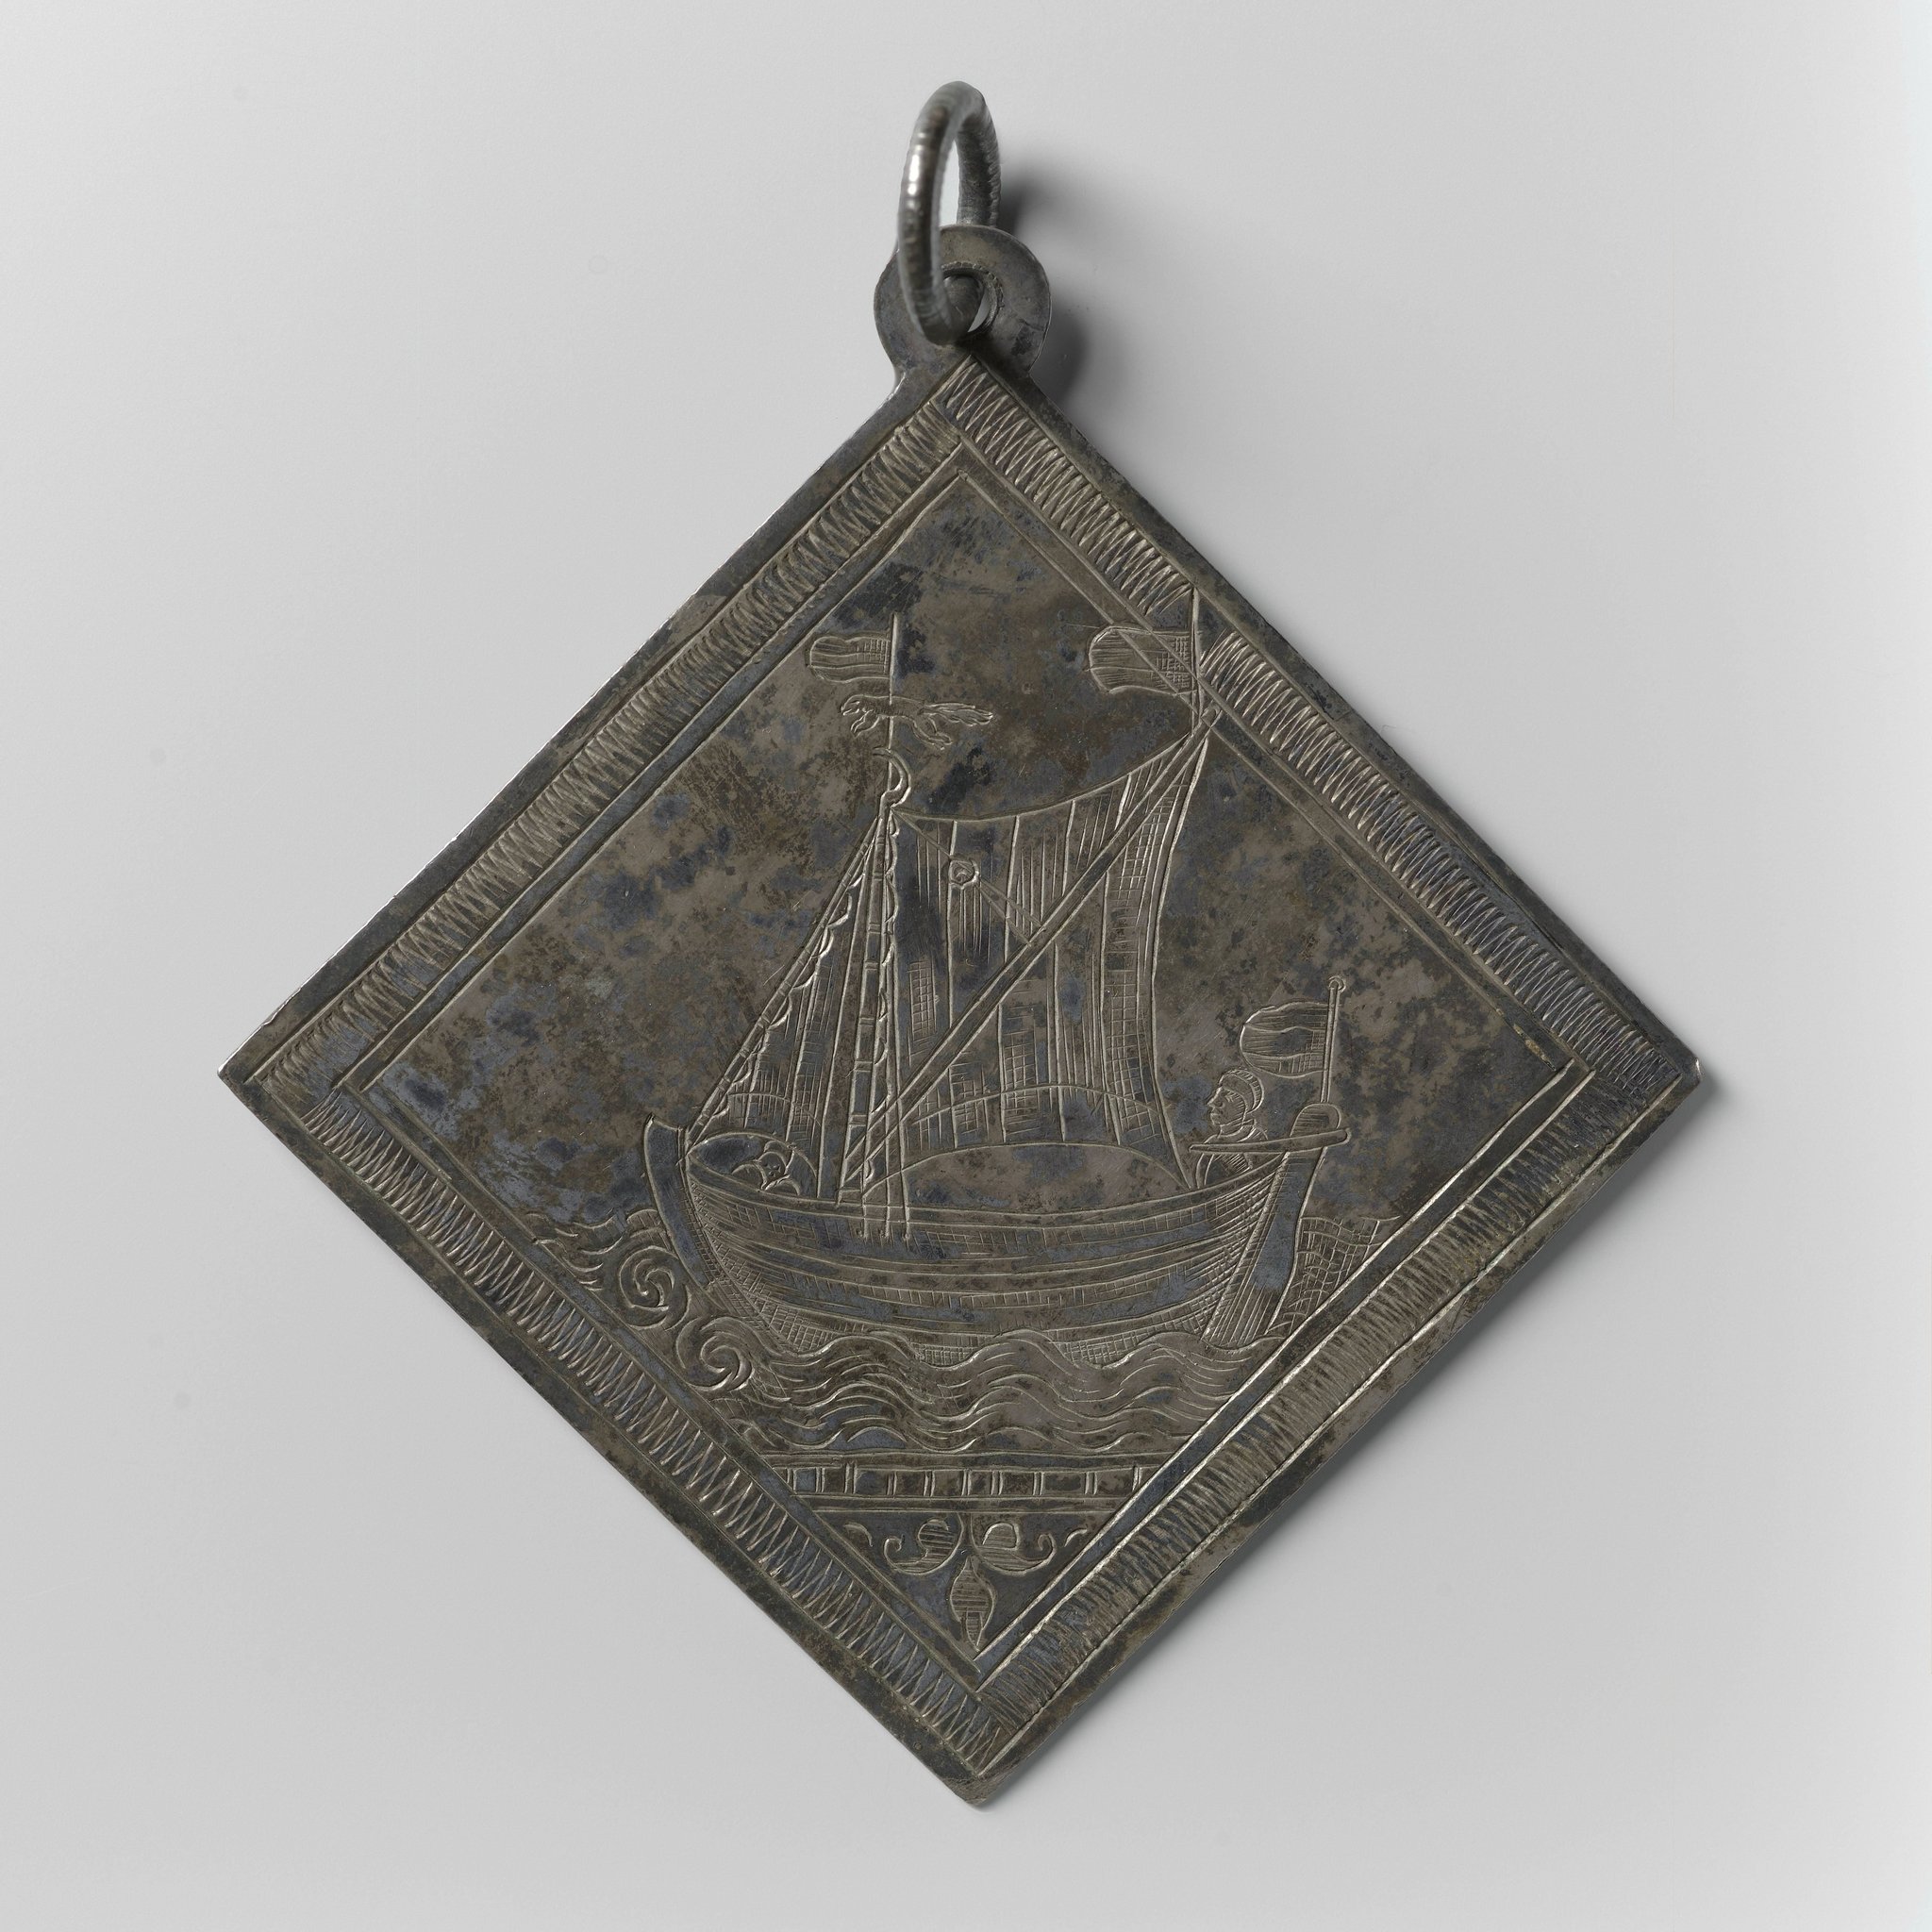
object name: medal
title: Schippersgilde, gildepenning van Pieter Hermanse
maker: Anonymous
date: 1600-1700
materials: silver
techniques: engraving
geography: zeeland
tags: pieter hermanse